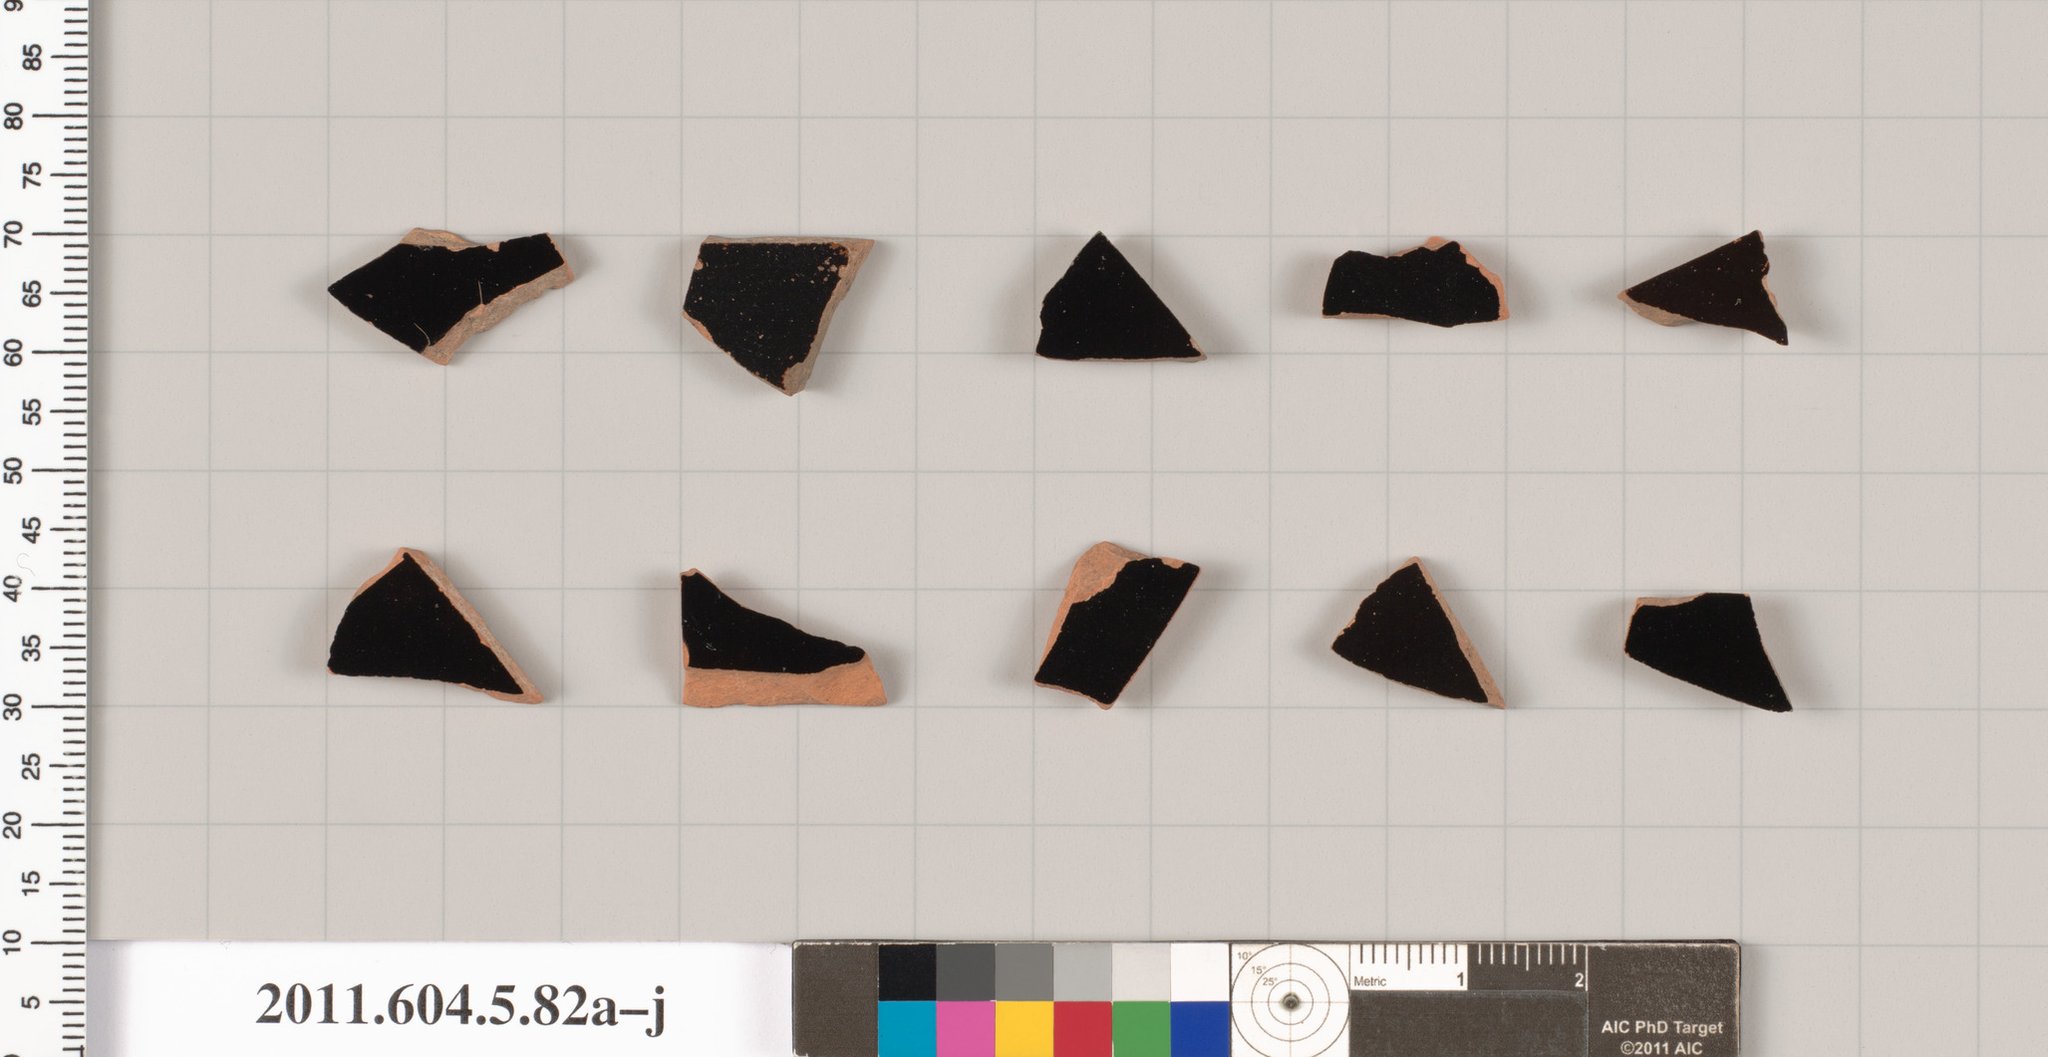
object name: kylix fragment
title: Terracotta fragments of kylikes (drinking cups)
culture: greek, attic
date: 534-468 BCE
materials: terracotta